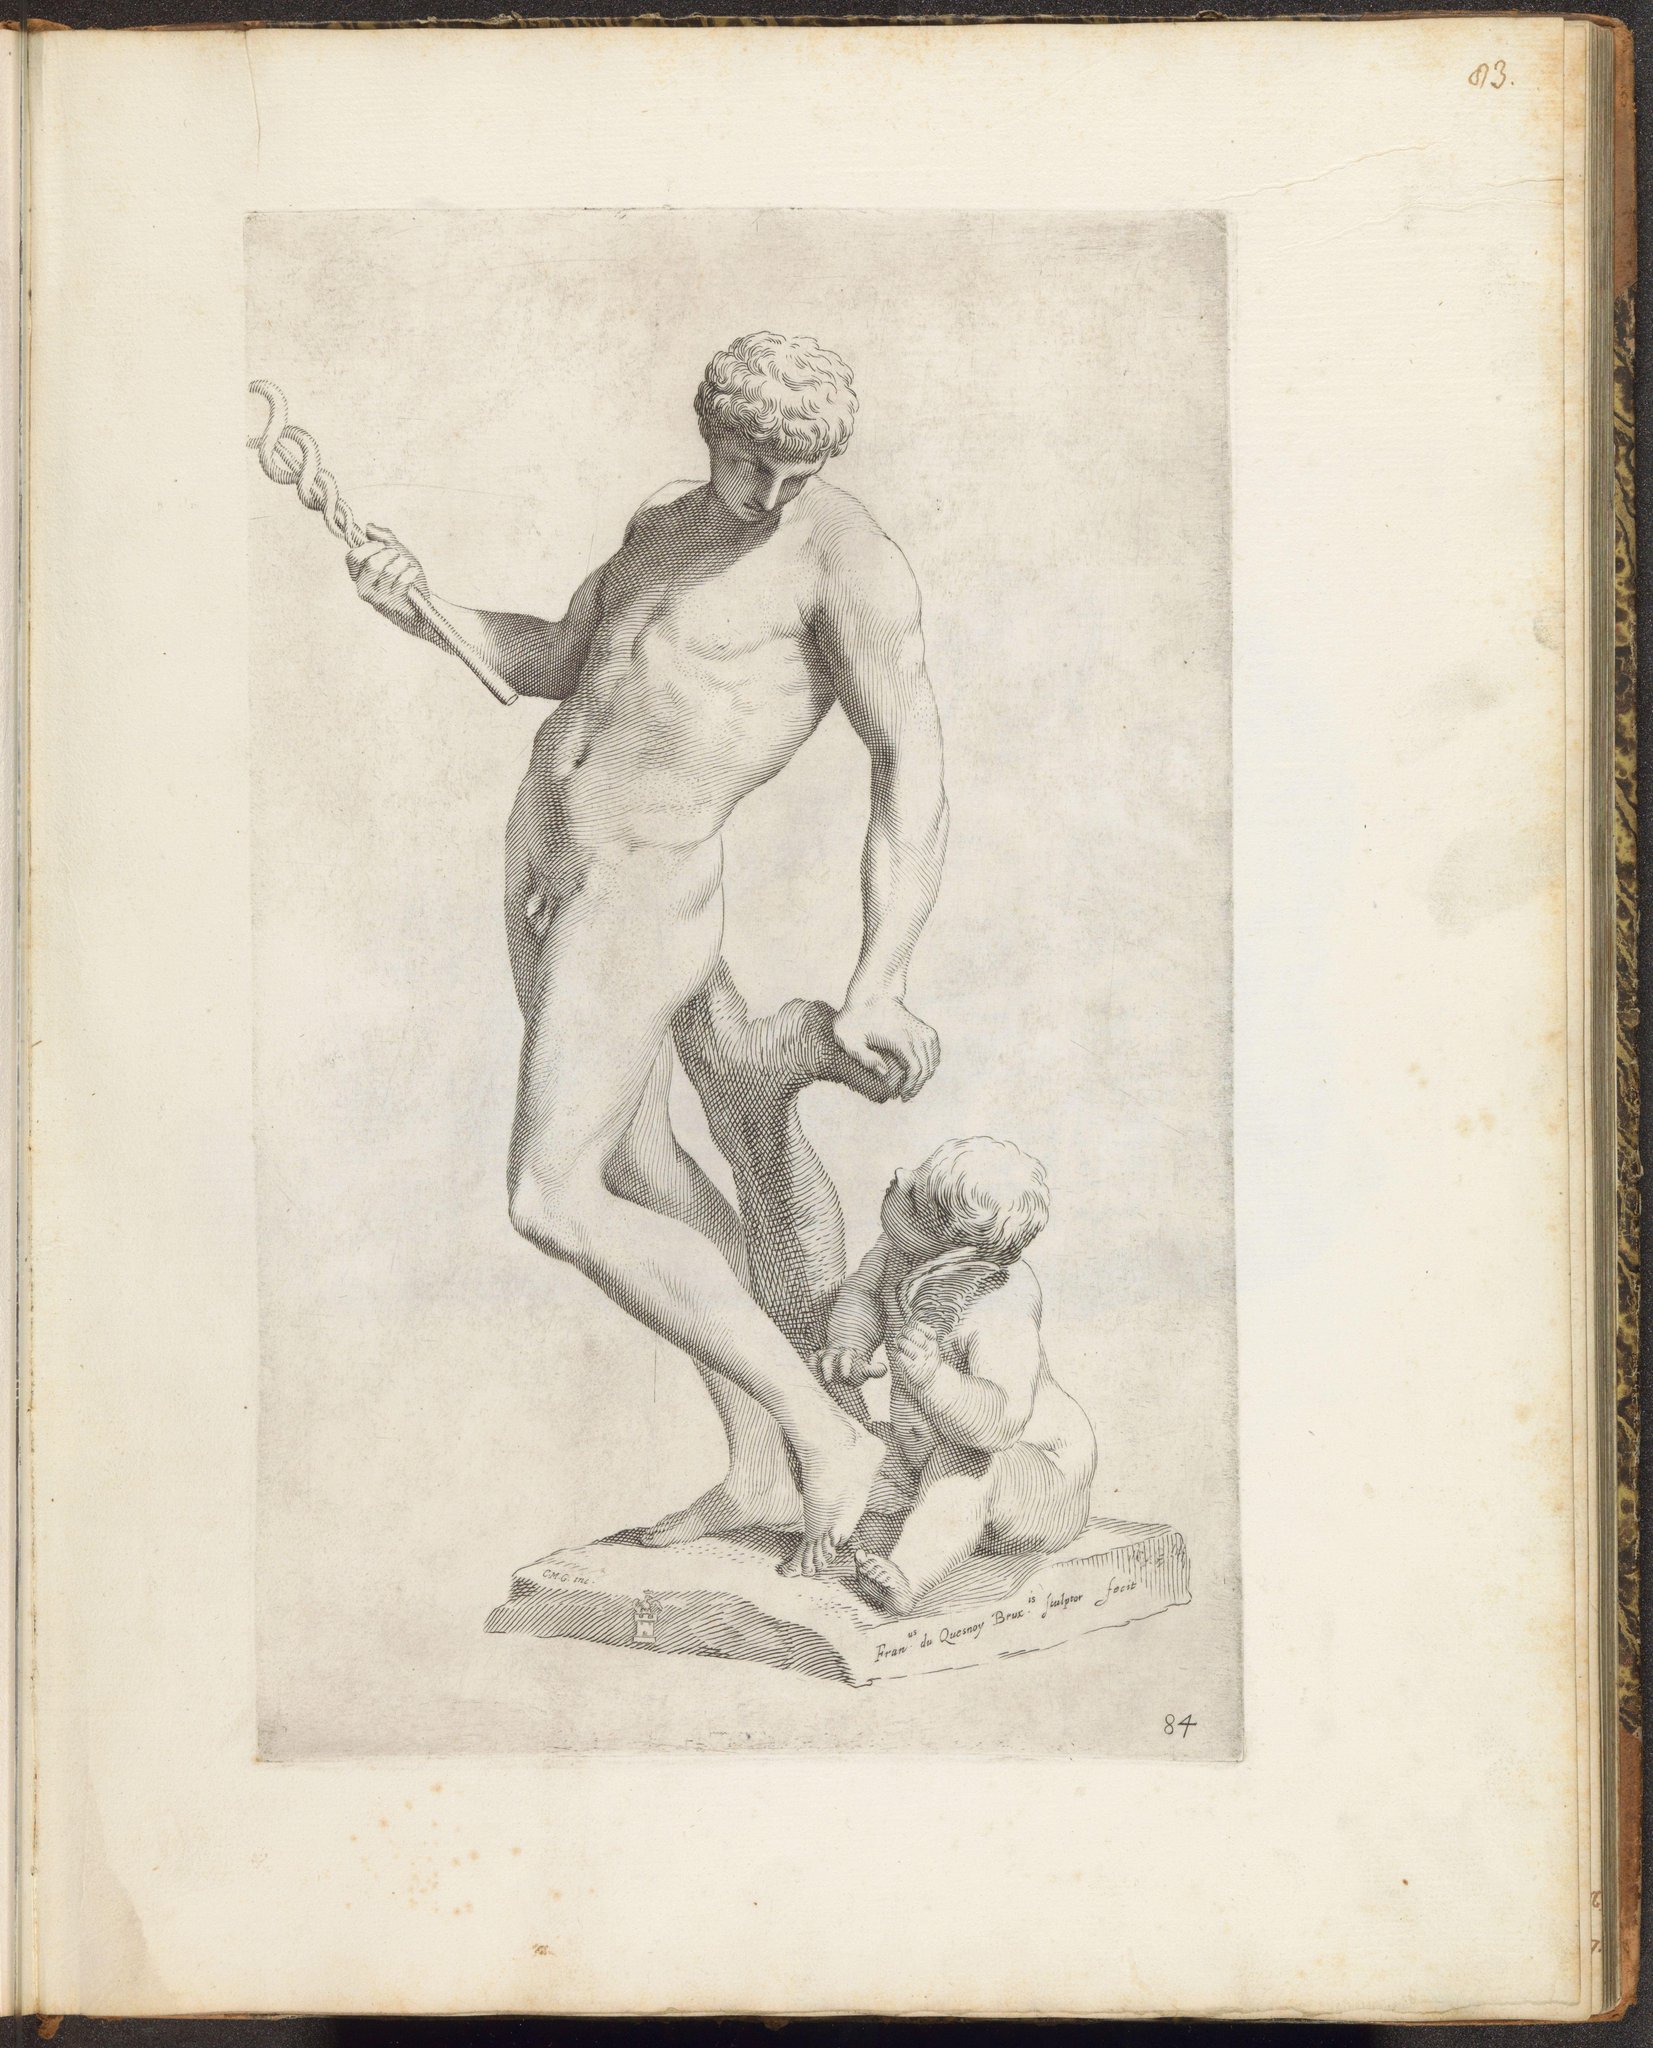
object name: album leaf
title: Standbeeld van Mercurius met een putto aan zijn voeten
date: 1636-1647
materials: paper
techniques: engraving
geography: rome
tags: (story of) mercury (hermes), attributes of mercury: petasus, attributes of mercury: winged sandals, piece of sculpture, reproduction of a piece of sculpture, caduceus (staff with two snakes, attribute of mercury)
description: Standbeeld van Mercurius, met de caduceus in de hand. Hij kijkt naar beneden naar de putto aan zijn voeten. Die heeft de vleugels van zijn voeten in de hand. Op de basis het wapenschild van Vincenzo Giustiniani. Prent maakt deel uit van een album met een serie prenten naar de sculpturen in de verzameling in de Galleria Giustiniani te Rome.